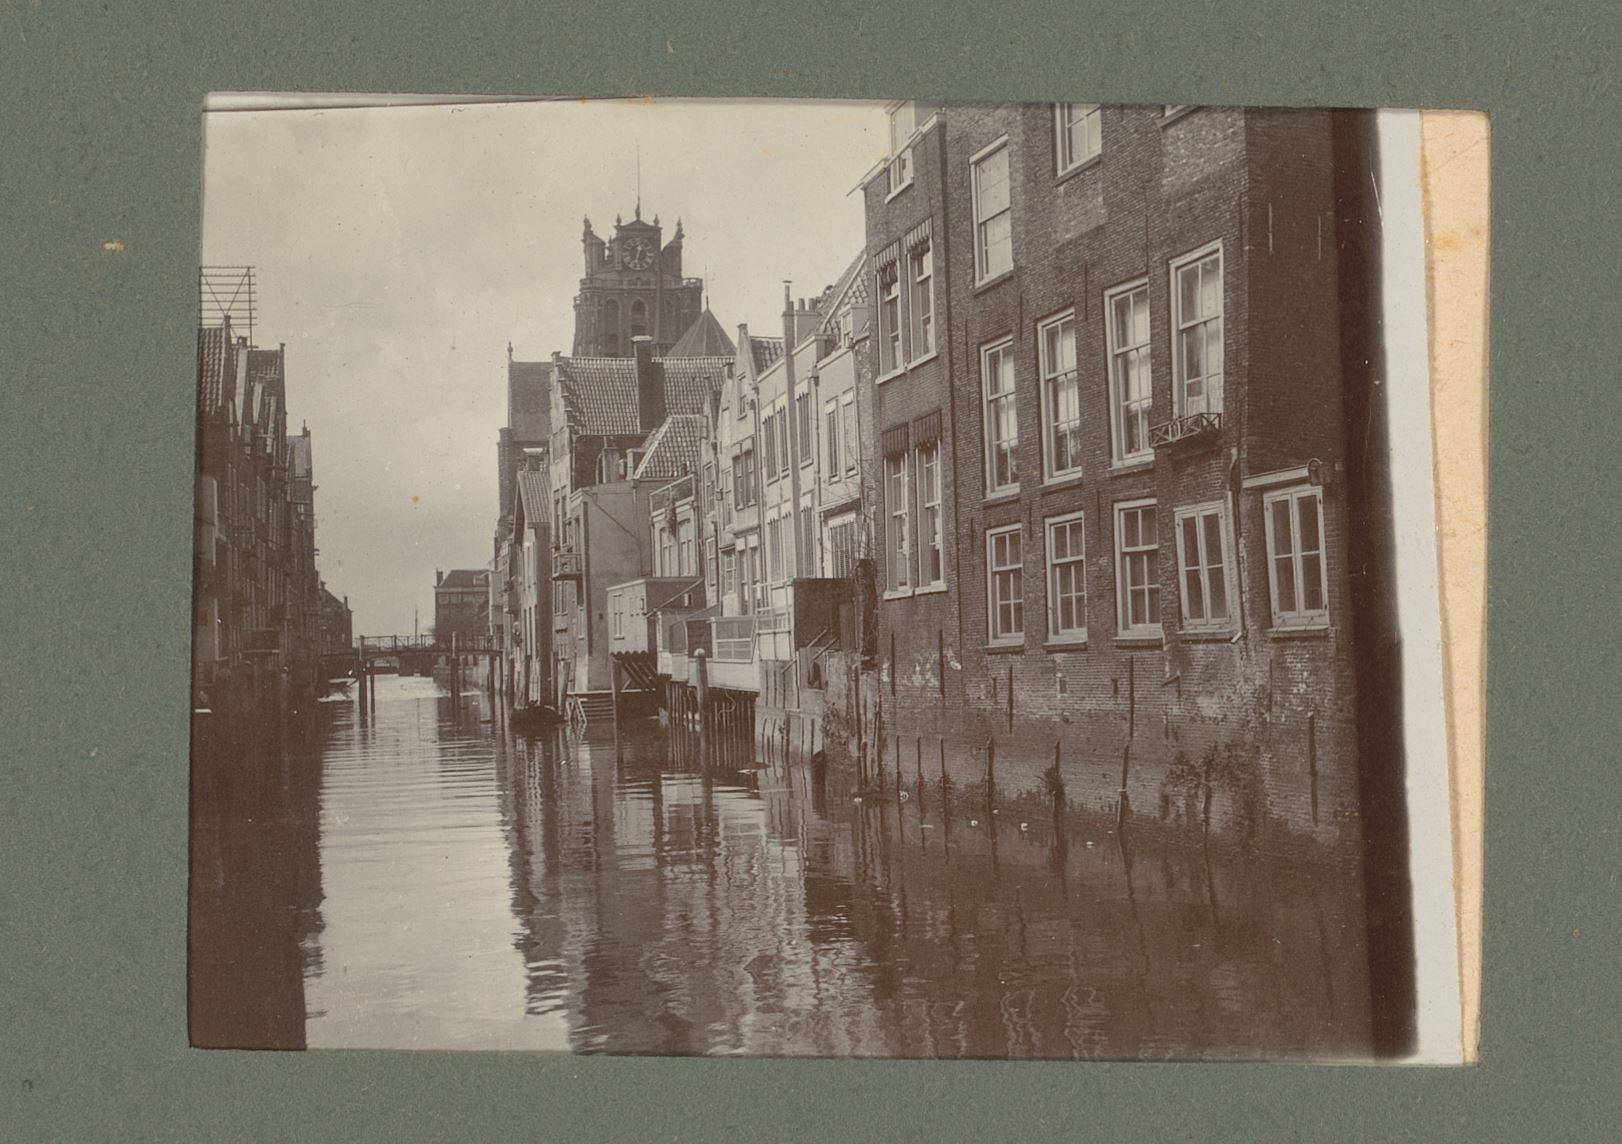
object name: photograph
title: Gezicht op de Wijnhaven richting de Leuvehaven en de Grote of Onze-Lieve-Vrouwekerk te Dordrecht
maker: george hidderley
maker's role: fotograaf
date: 1900-1920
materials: photographic support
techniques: gelatin silver print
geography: netherlands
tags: urban housing, canals, waters (in city), parts of church exterior and annexes: tower